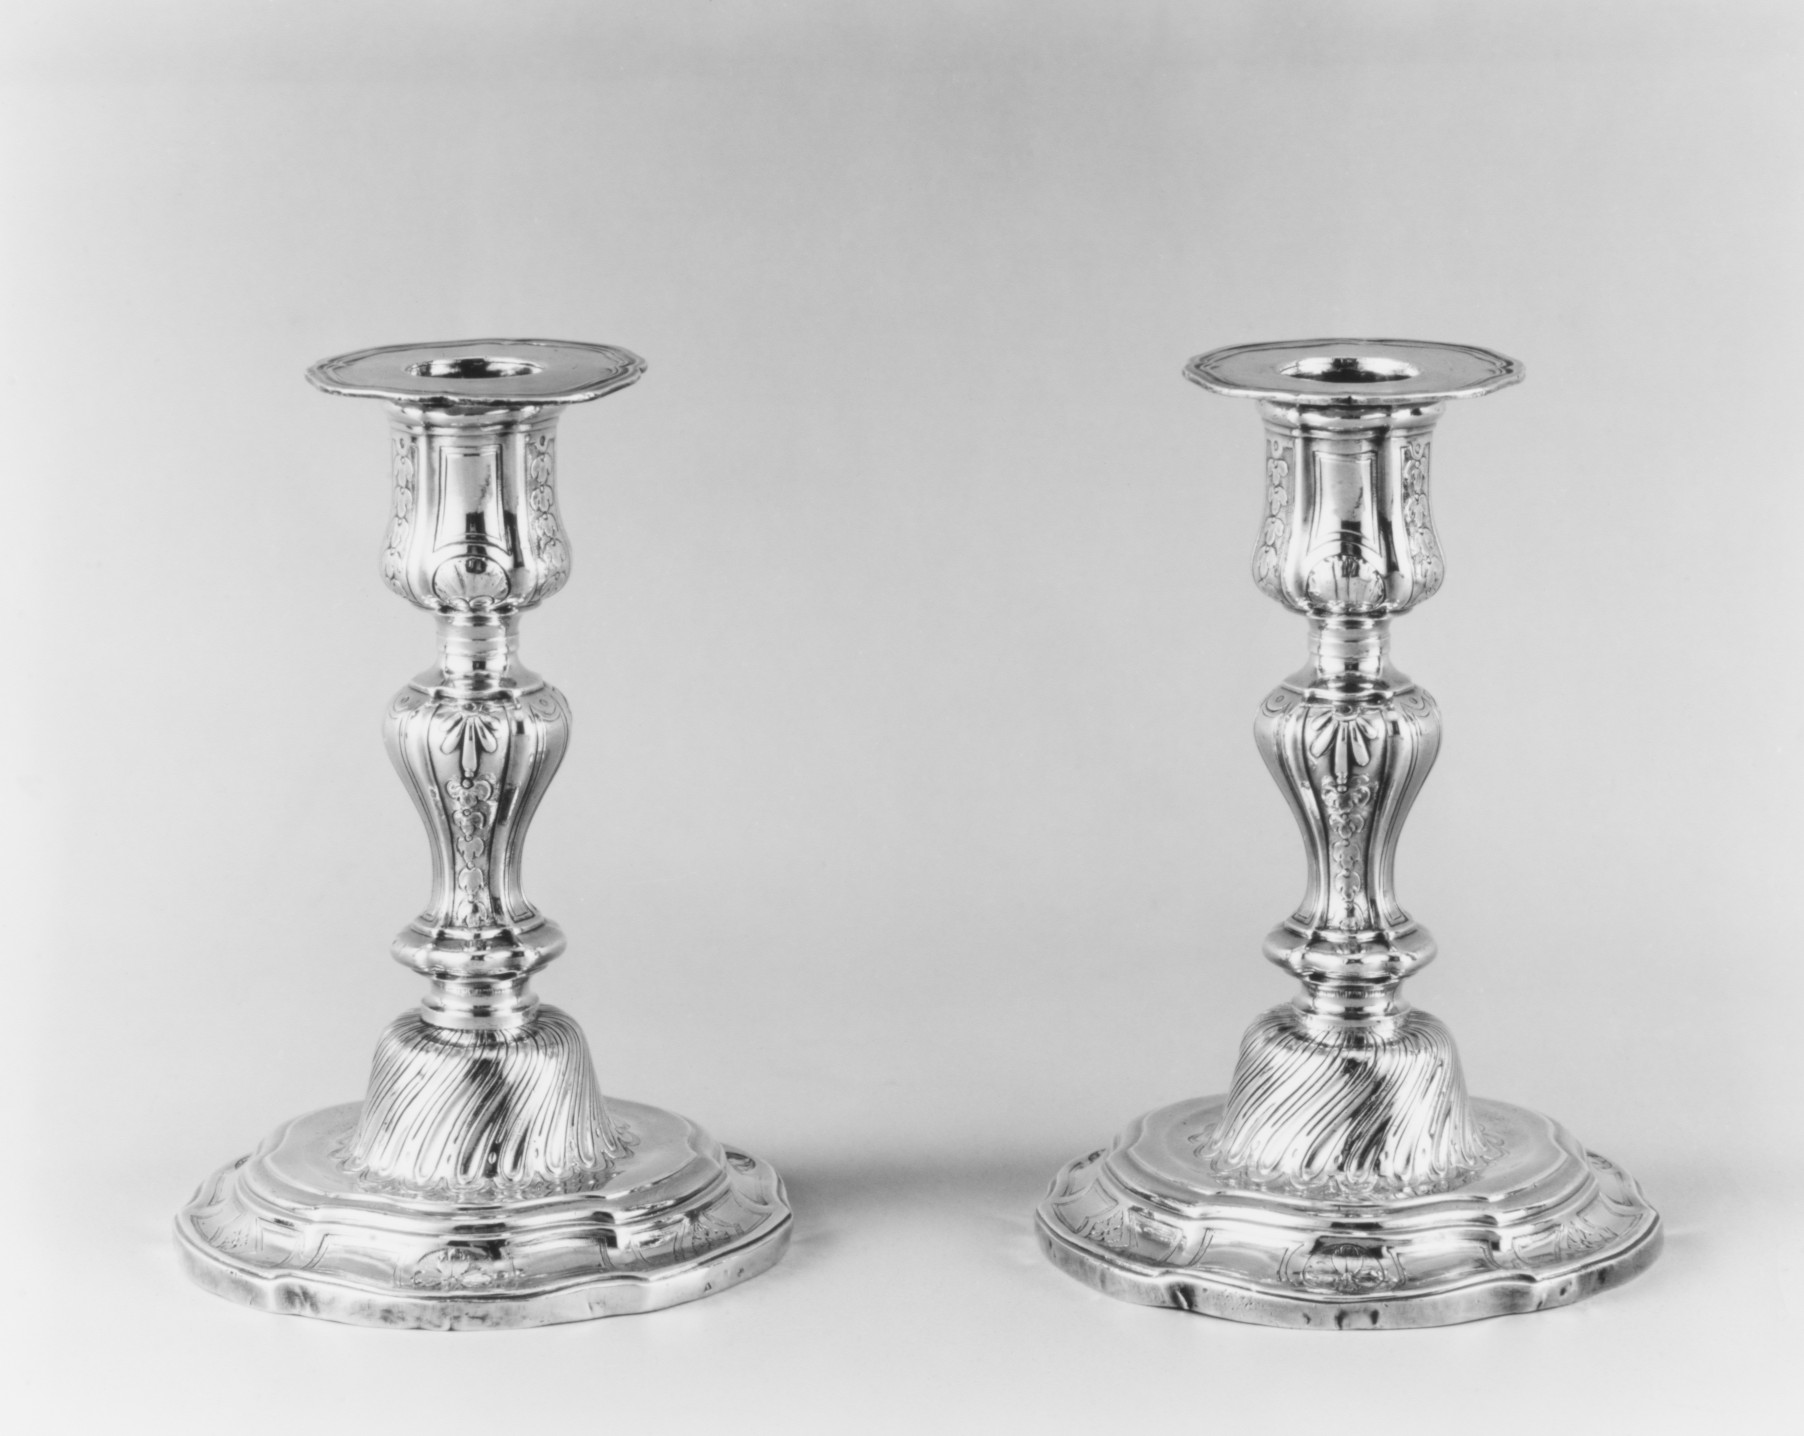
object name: candlestick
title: Pair of candlesticks (part of a toilet service)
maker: joseph charvet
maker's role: maker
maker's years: 1670-1770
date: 1758-1759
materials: silver